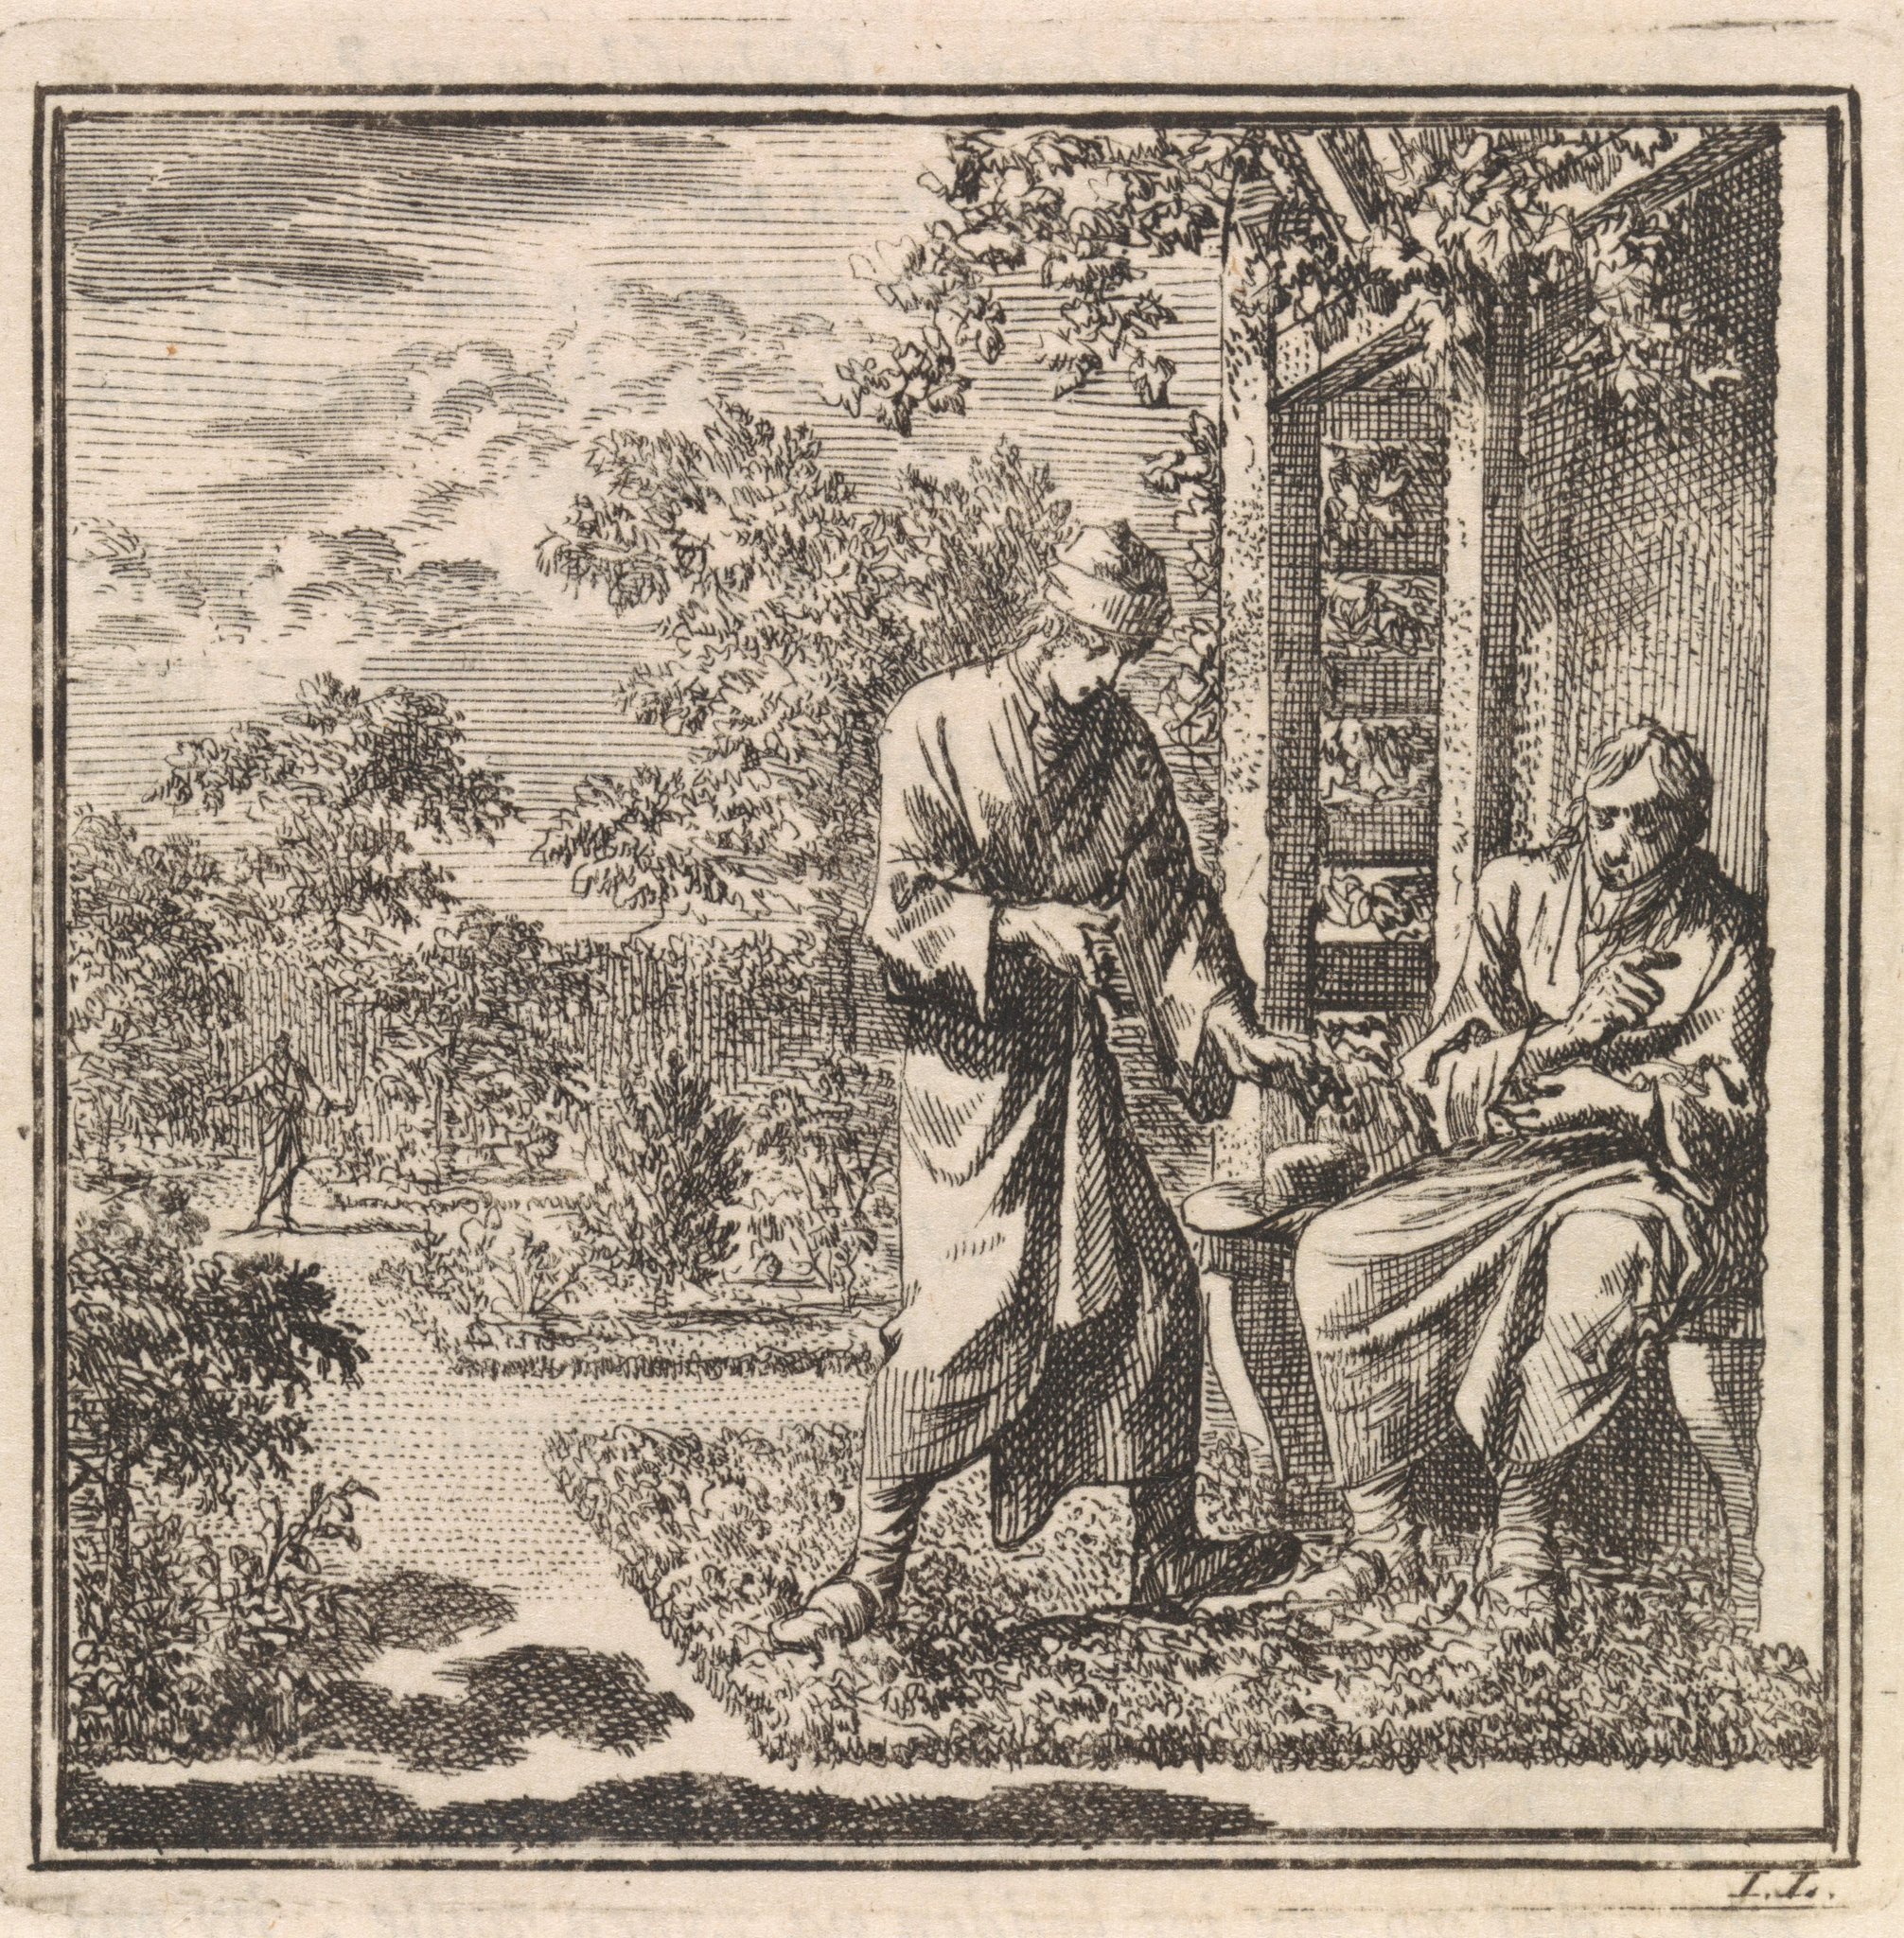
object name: print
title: Twee mannen in een tuin bij een prieeltje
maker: jan luyken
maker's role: draughtsman, print maker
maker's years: 1649-1712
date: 1711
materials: paper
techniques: etching, letterpress printing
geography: amsterdam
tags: garden, summer-house, arbour, garden-house (dutch: 'theekoepel')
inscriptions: collector's mark: Lugt 2228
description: Illustratie voor: Luyken, Jan. De Bykorf des Gemoeds. Amsterdam: Pieter Arentsz. II (wed.) en Cornelis van der Sys, 1711, p. 102.